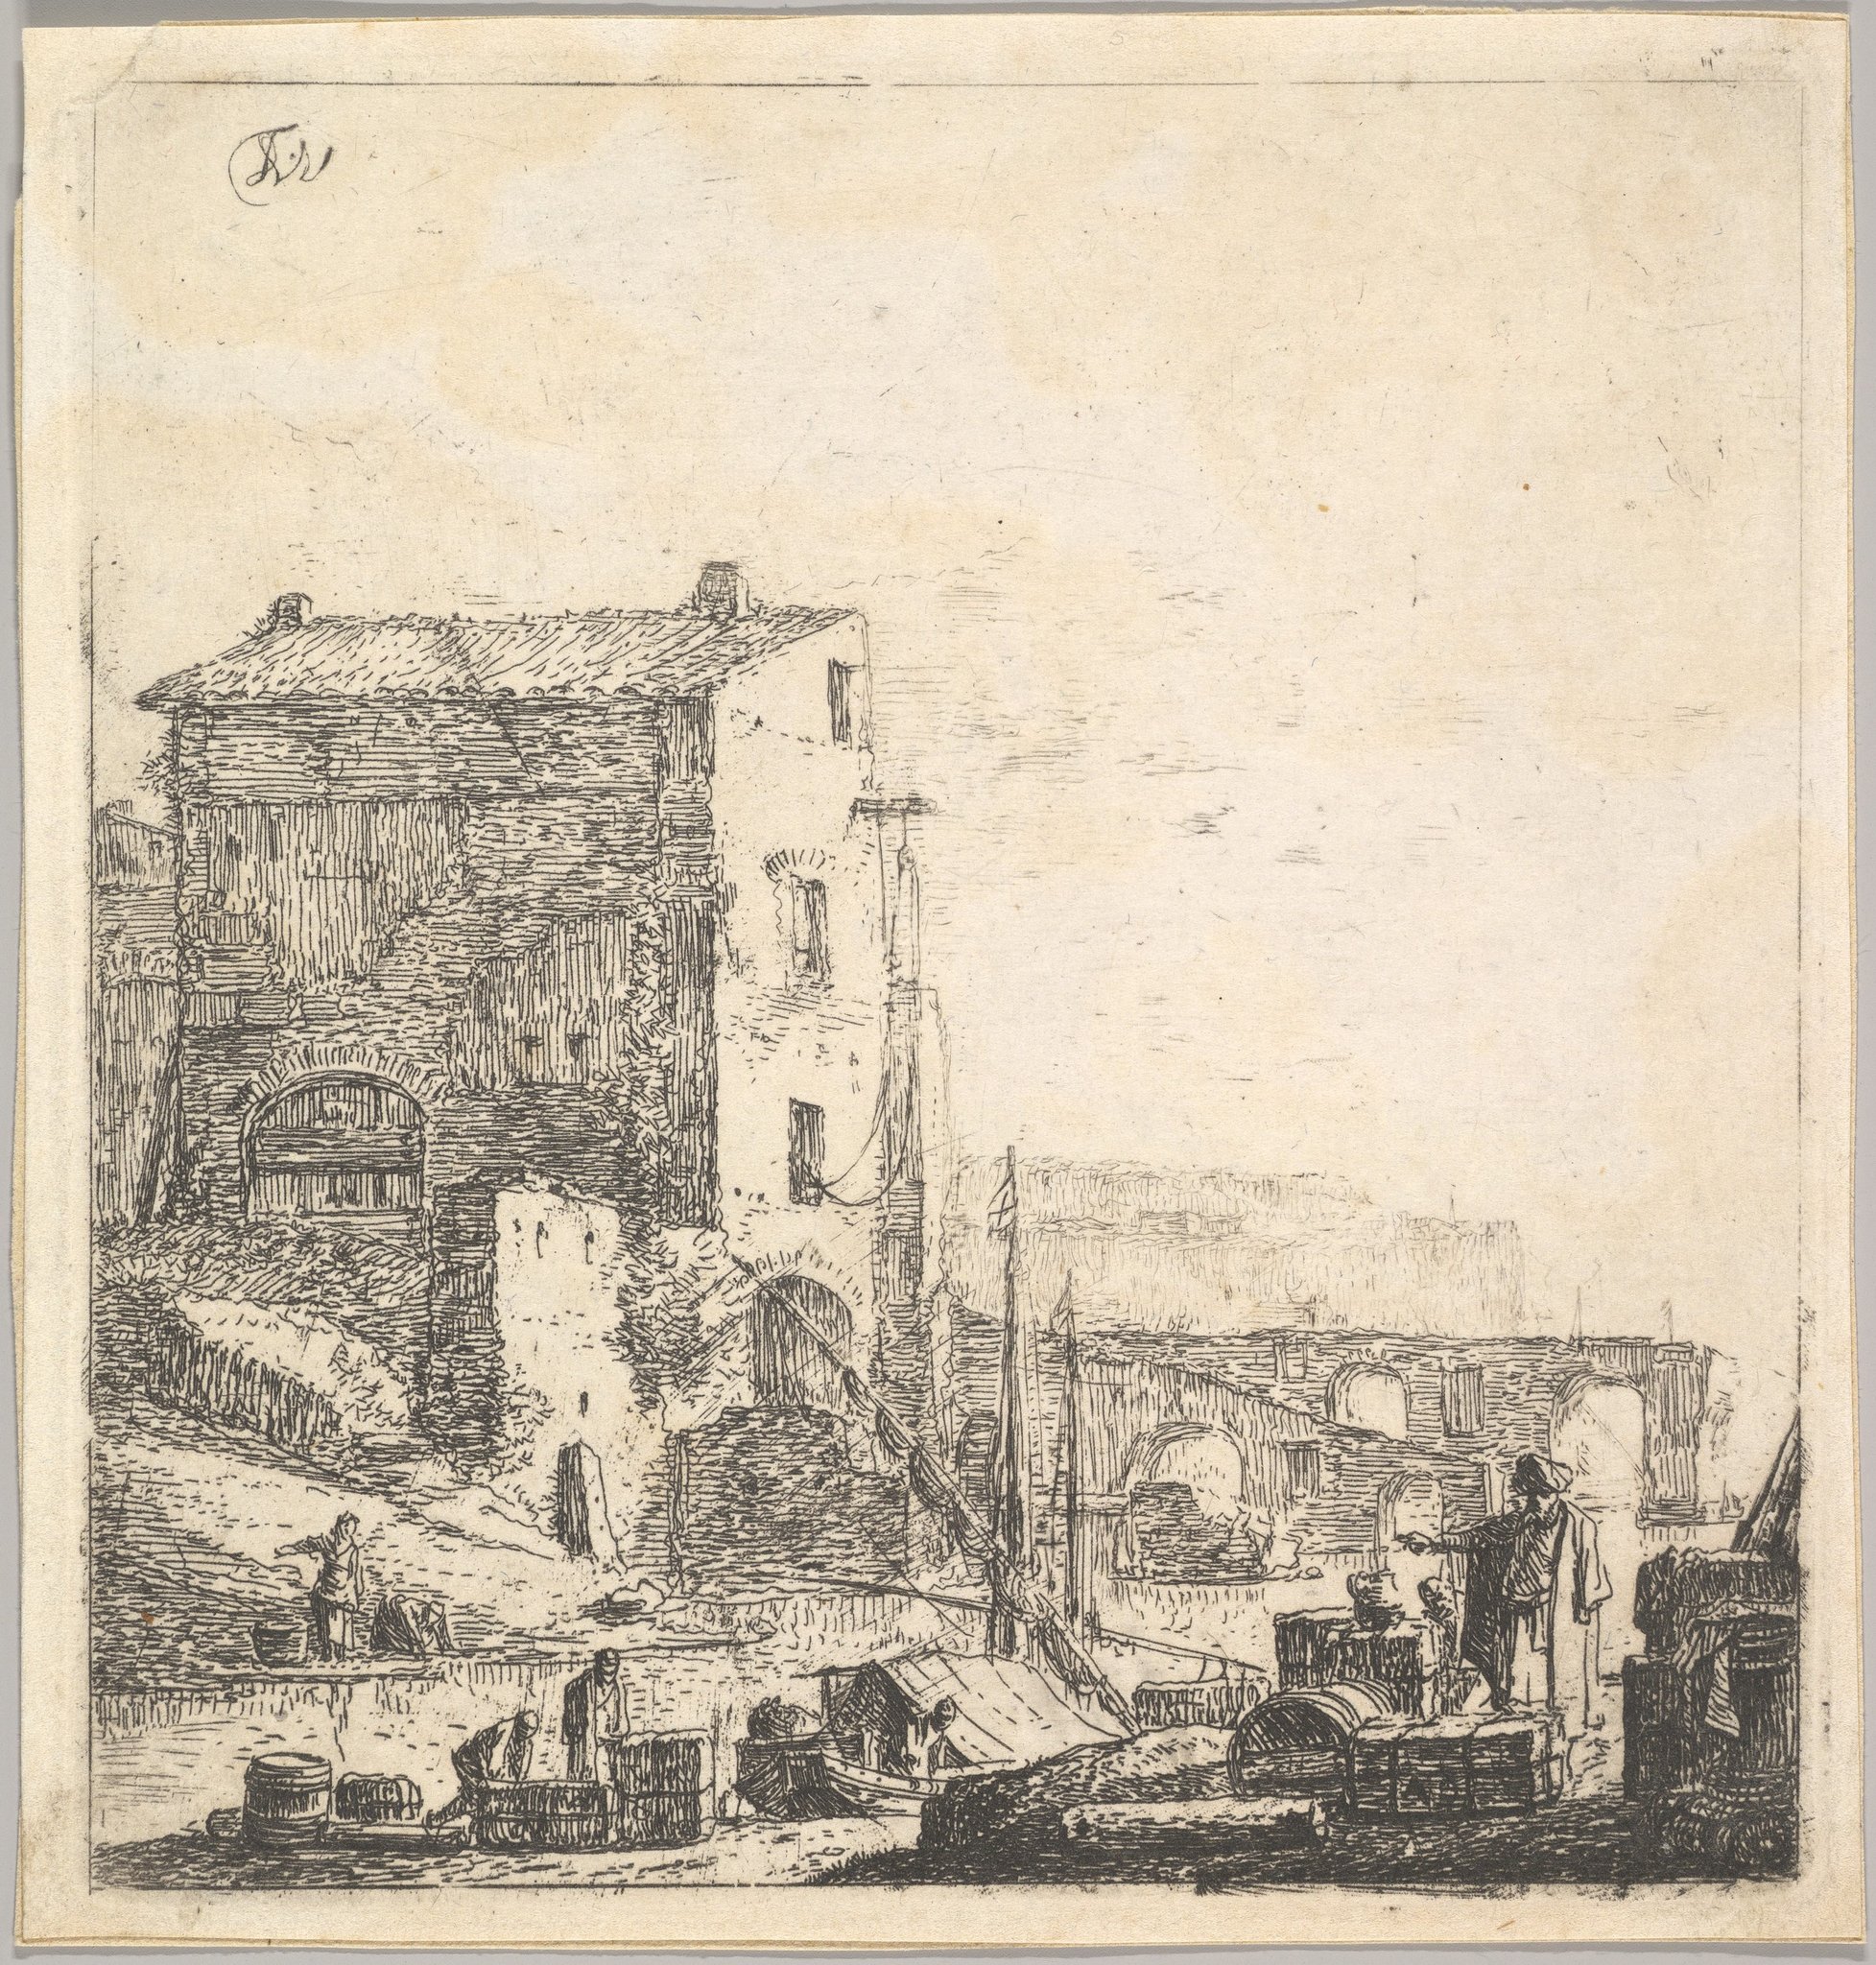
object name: print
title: An Oriental Merchant with Merchandise at Riverside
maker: thomas wijck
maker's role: artist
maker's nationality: dutch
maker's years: 1616-1677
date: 1601-1700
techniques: etching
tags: buildings,men,rivers,merchants,boats